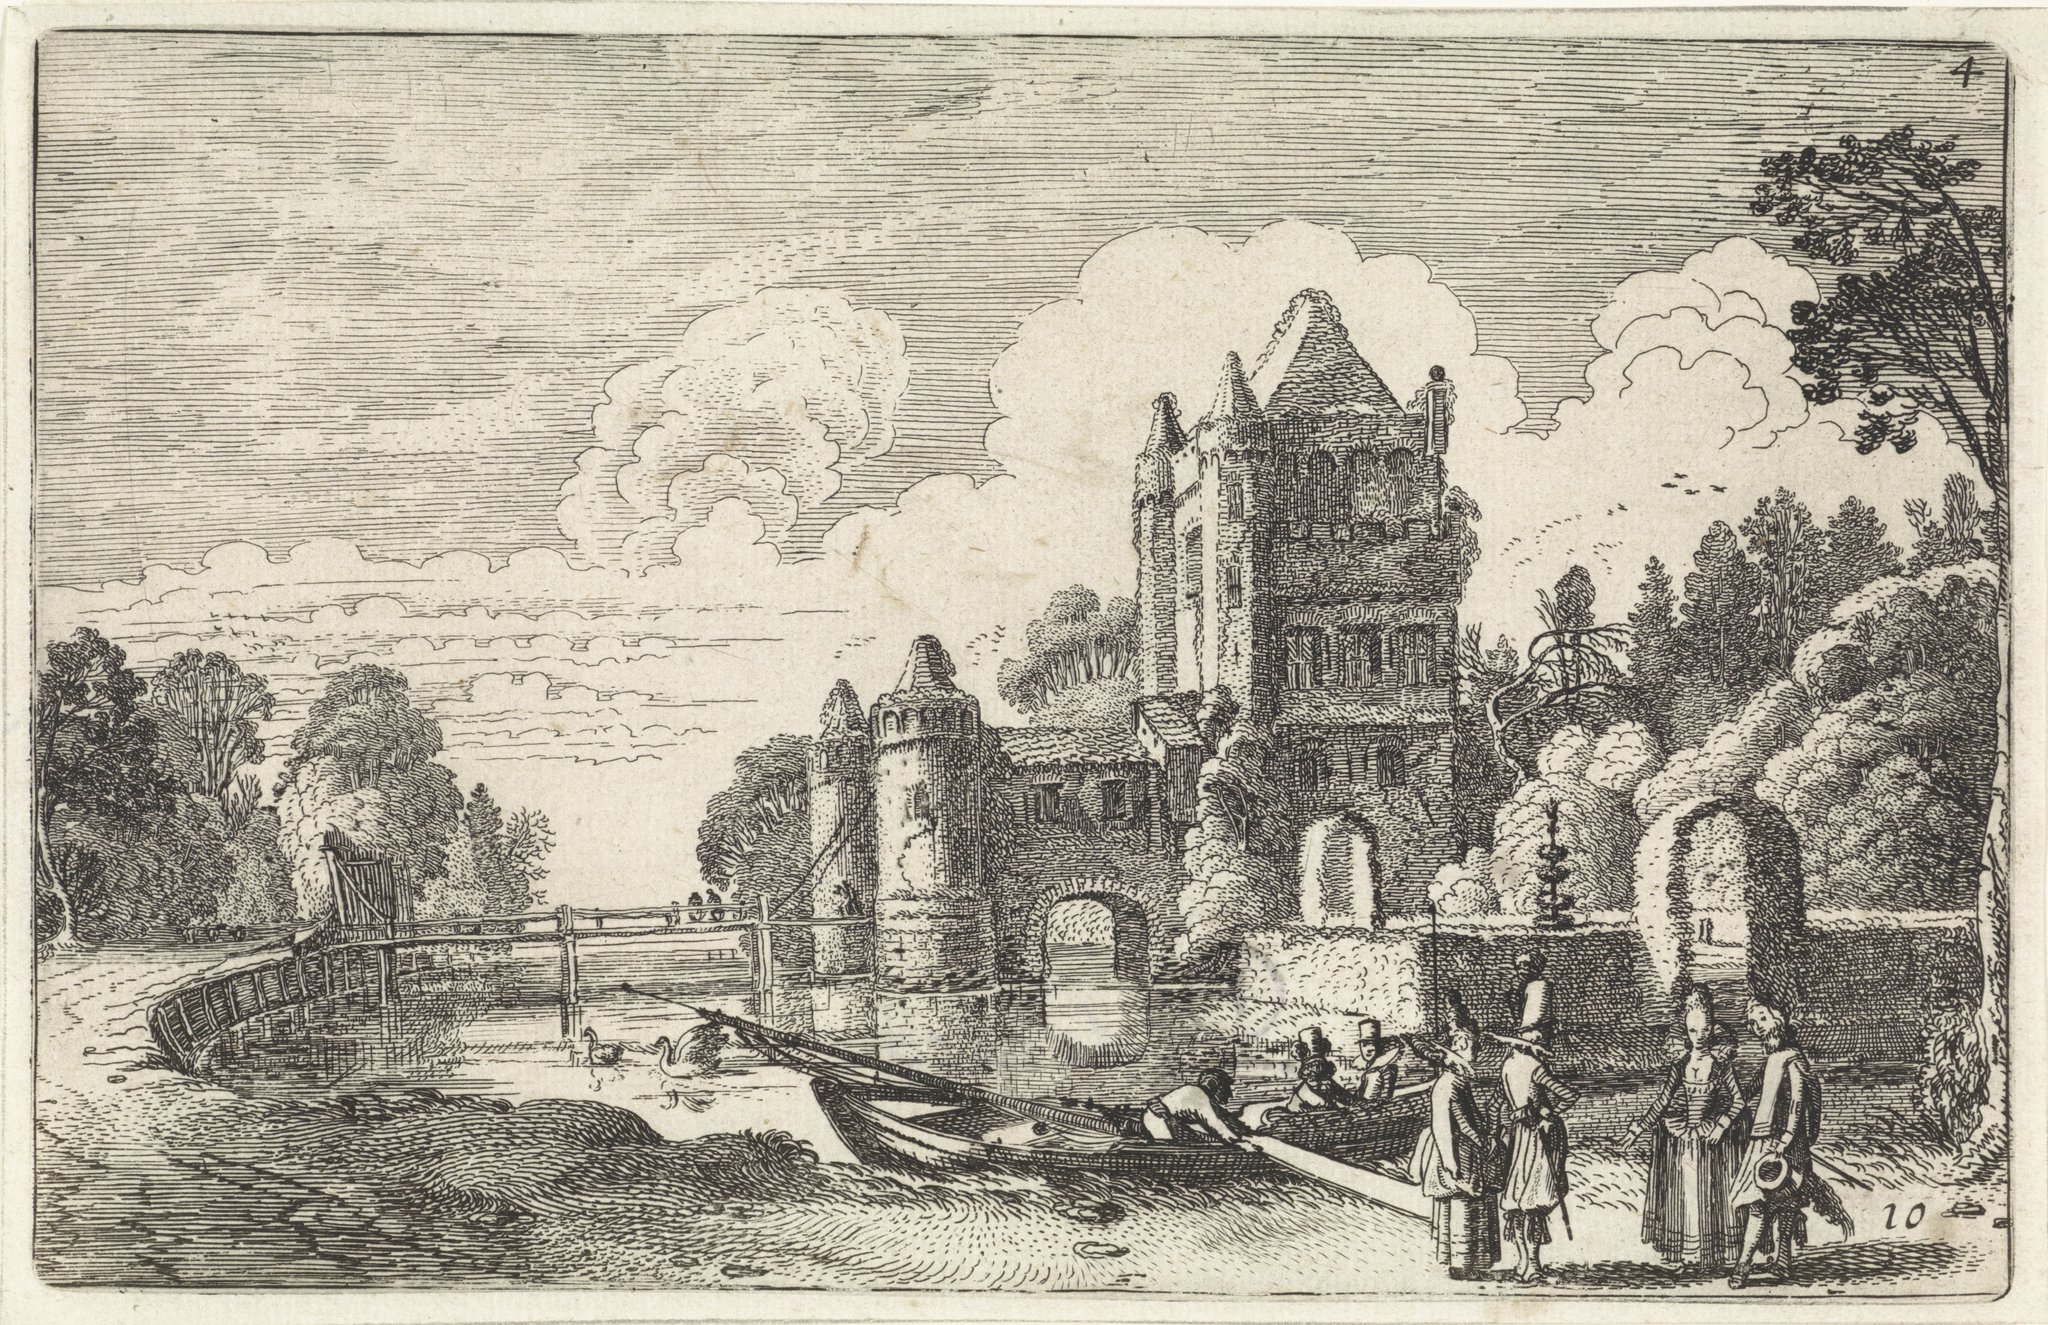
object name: print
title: Amenissimae aliquot requculae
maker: jan van de velde (ii)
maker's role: draughtsman, painter, print maker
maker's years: 1593-1641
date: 1616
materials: paper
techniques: etching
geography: northern netherlands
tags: passengers ~ ship (+ preparations ~ departure), landscape with tower or castle, city-gate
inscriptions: collector's mark: Lugt 964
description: Landschap met de Amsterdamse Poort te Haarlem. Op de voorgrond een elegant gezelschap bij een boot met een loopplank op de oever. Tiende prent van deel vier van een serie van in totaal zestig prenten met landschappen, verdeeld over vijf delen van elk twaalf prenten.